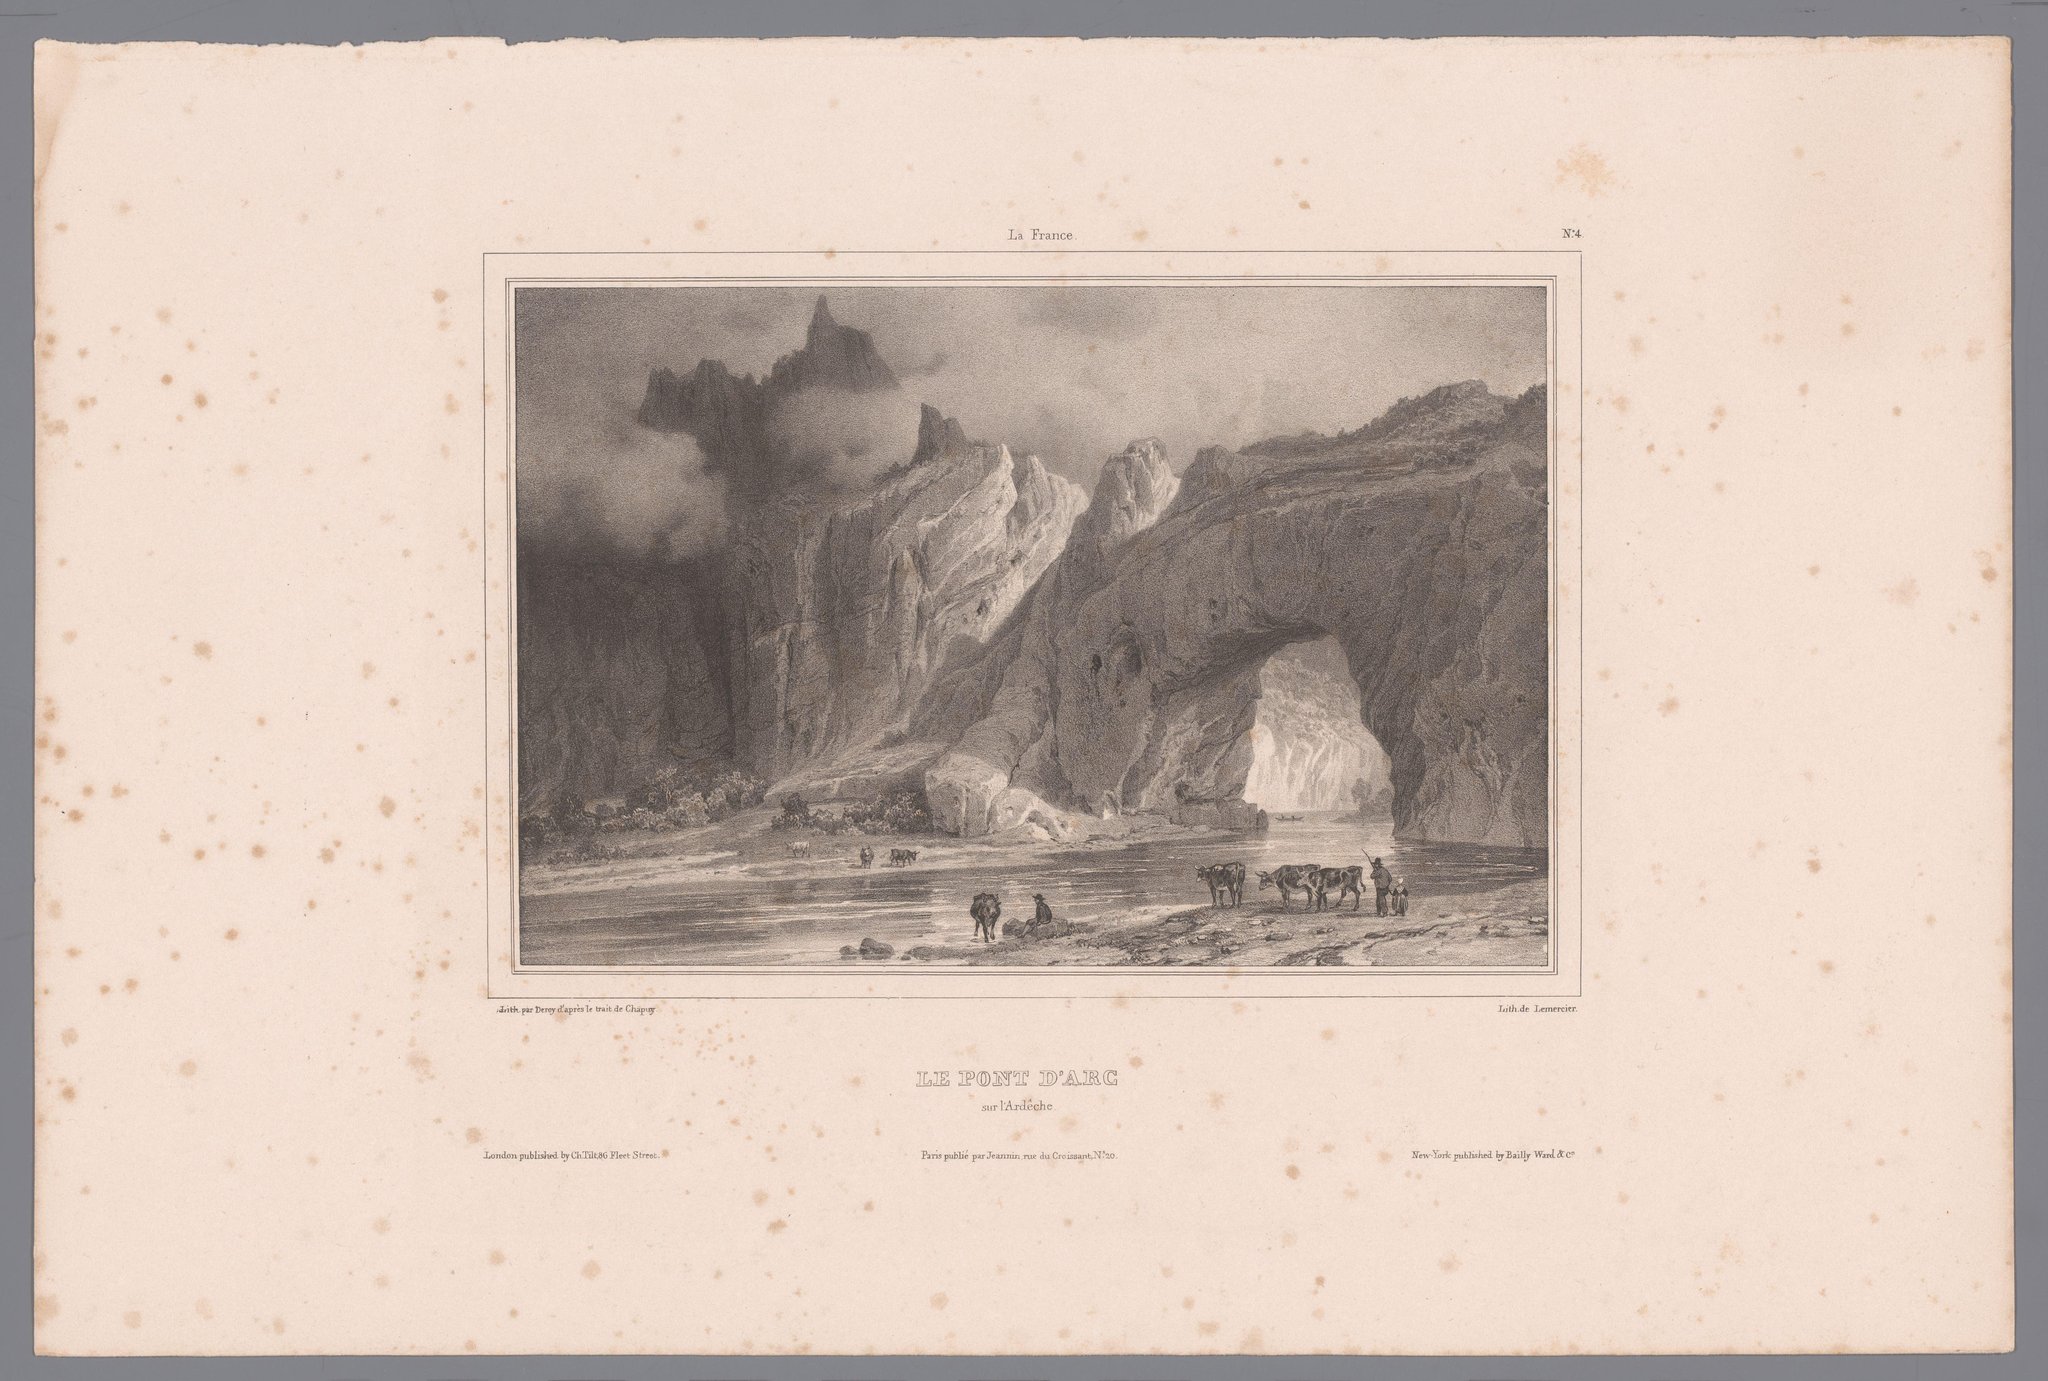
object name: print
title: Zicht op de Pont d'Arc over de Ardèche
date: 1834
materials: paper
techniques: lithograph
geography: london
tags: bridge forms, river (+ landscape with figures, staffage), rock-formations (+ landscape with figures, staffage)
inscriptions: collector's mark: Lugt 2228a, check stamp: Lugt 3987